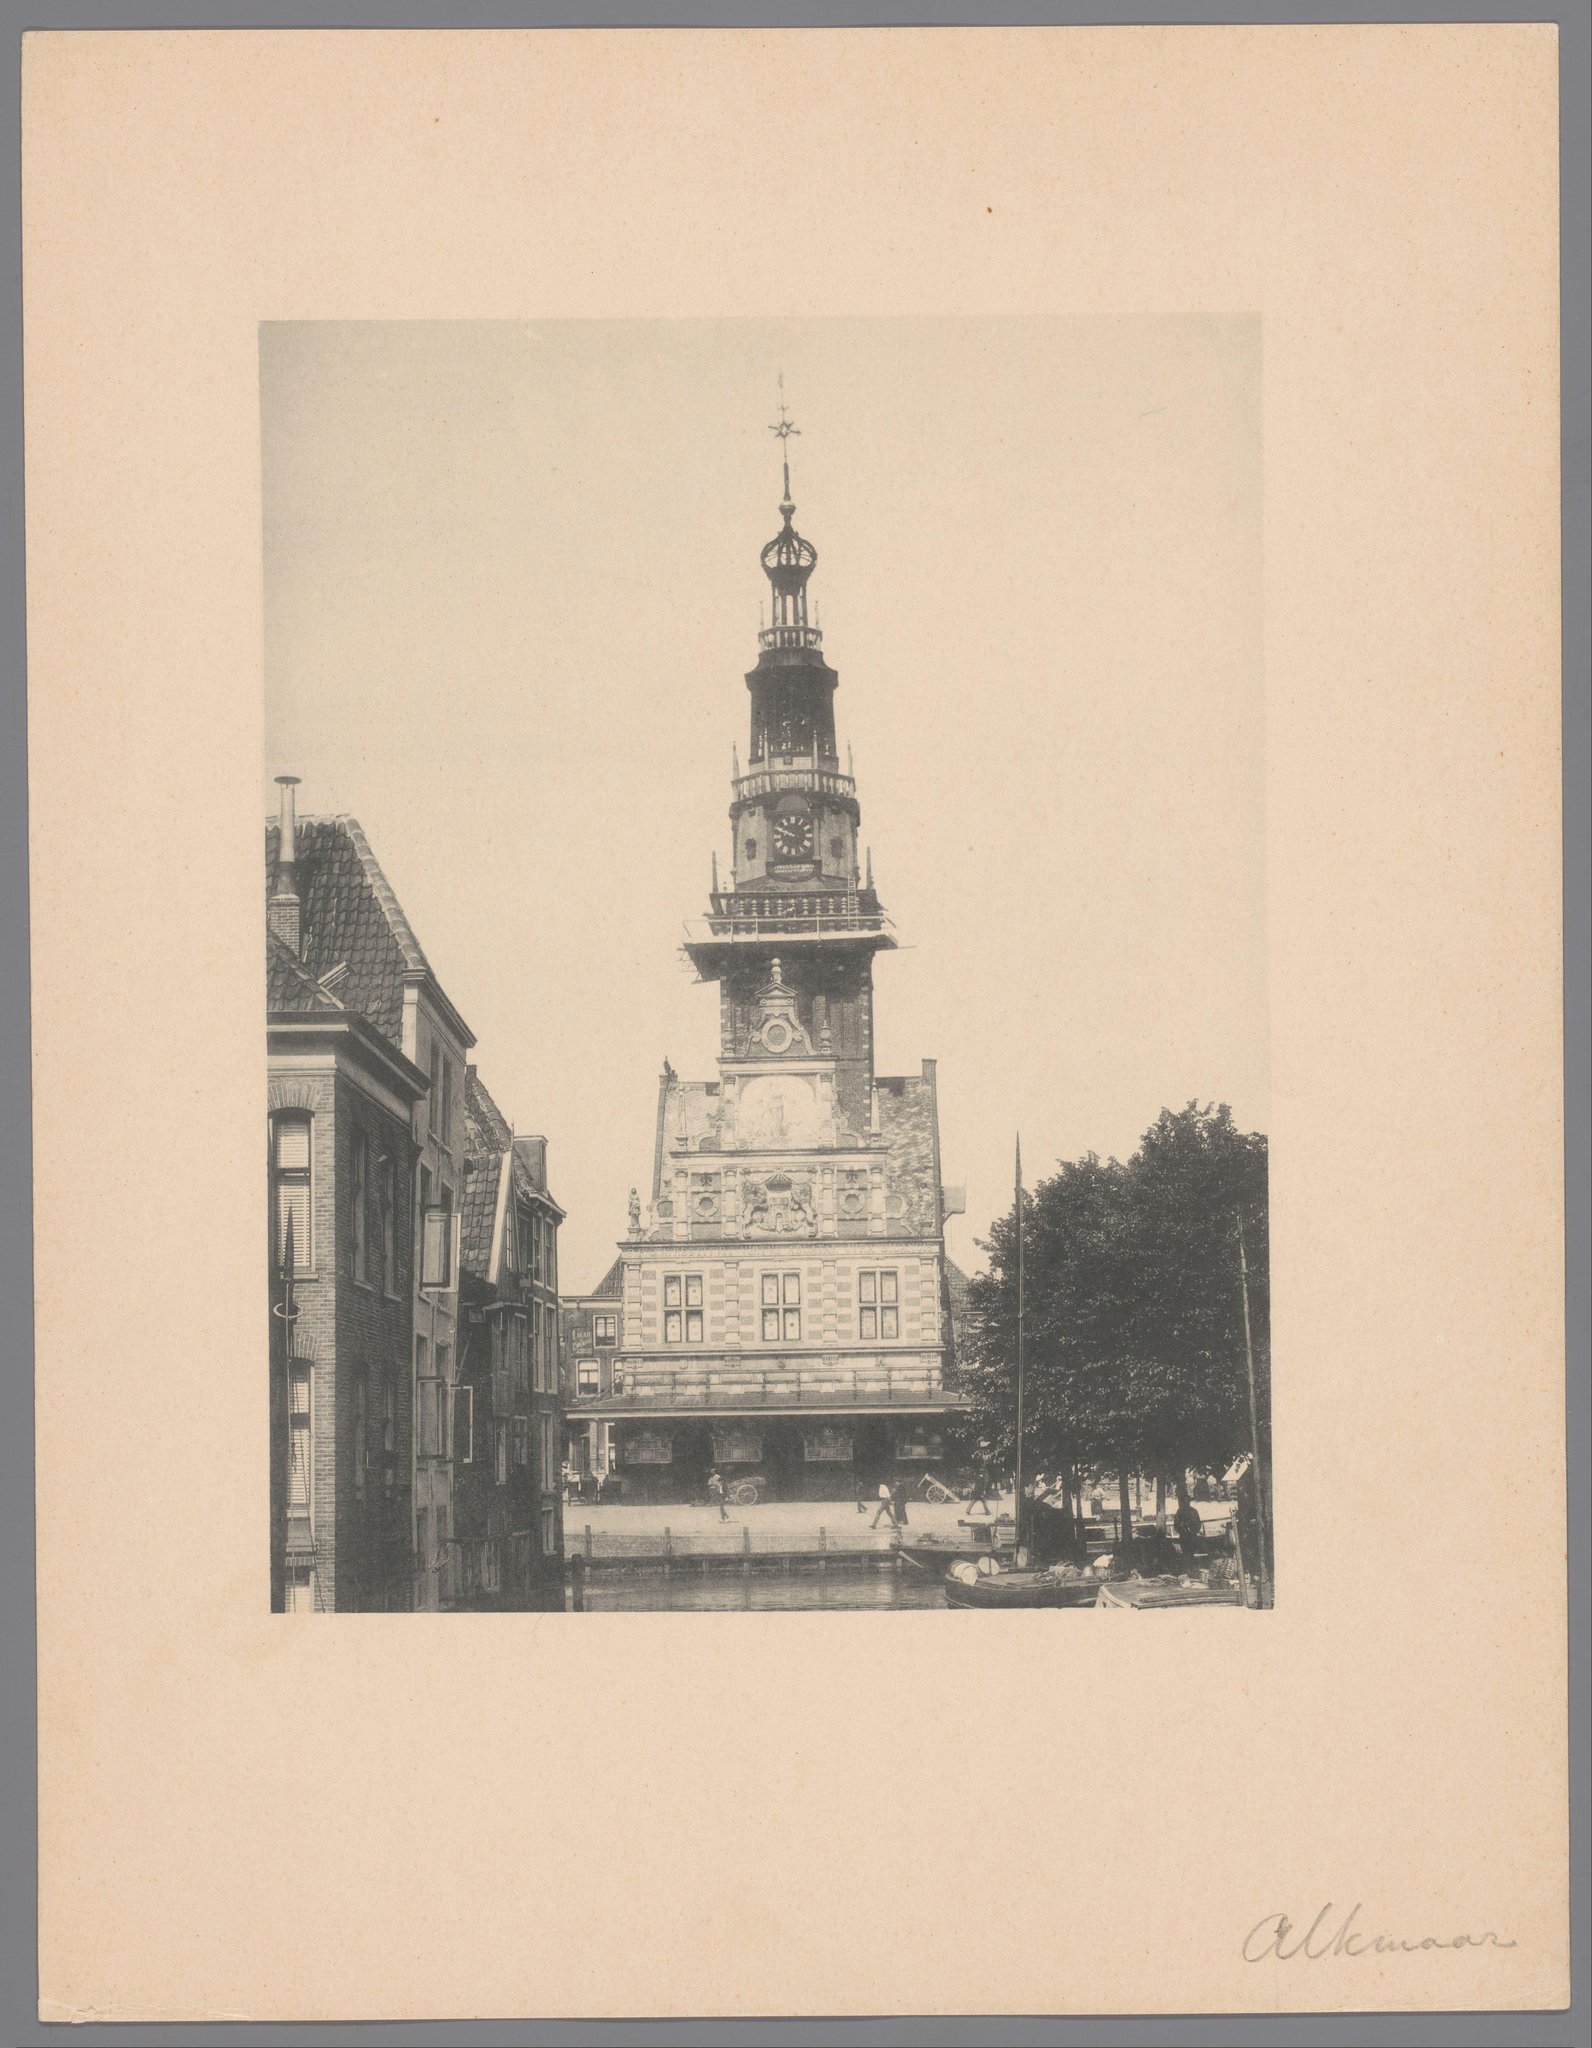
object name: photomechanical print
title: Gezicht op de waag te Alkmaar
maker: Anonymous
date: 1880-1920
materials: paper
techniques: photograph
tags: weigh-house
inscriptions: annotation: ‘Alkmaar’